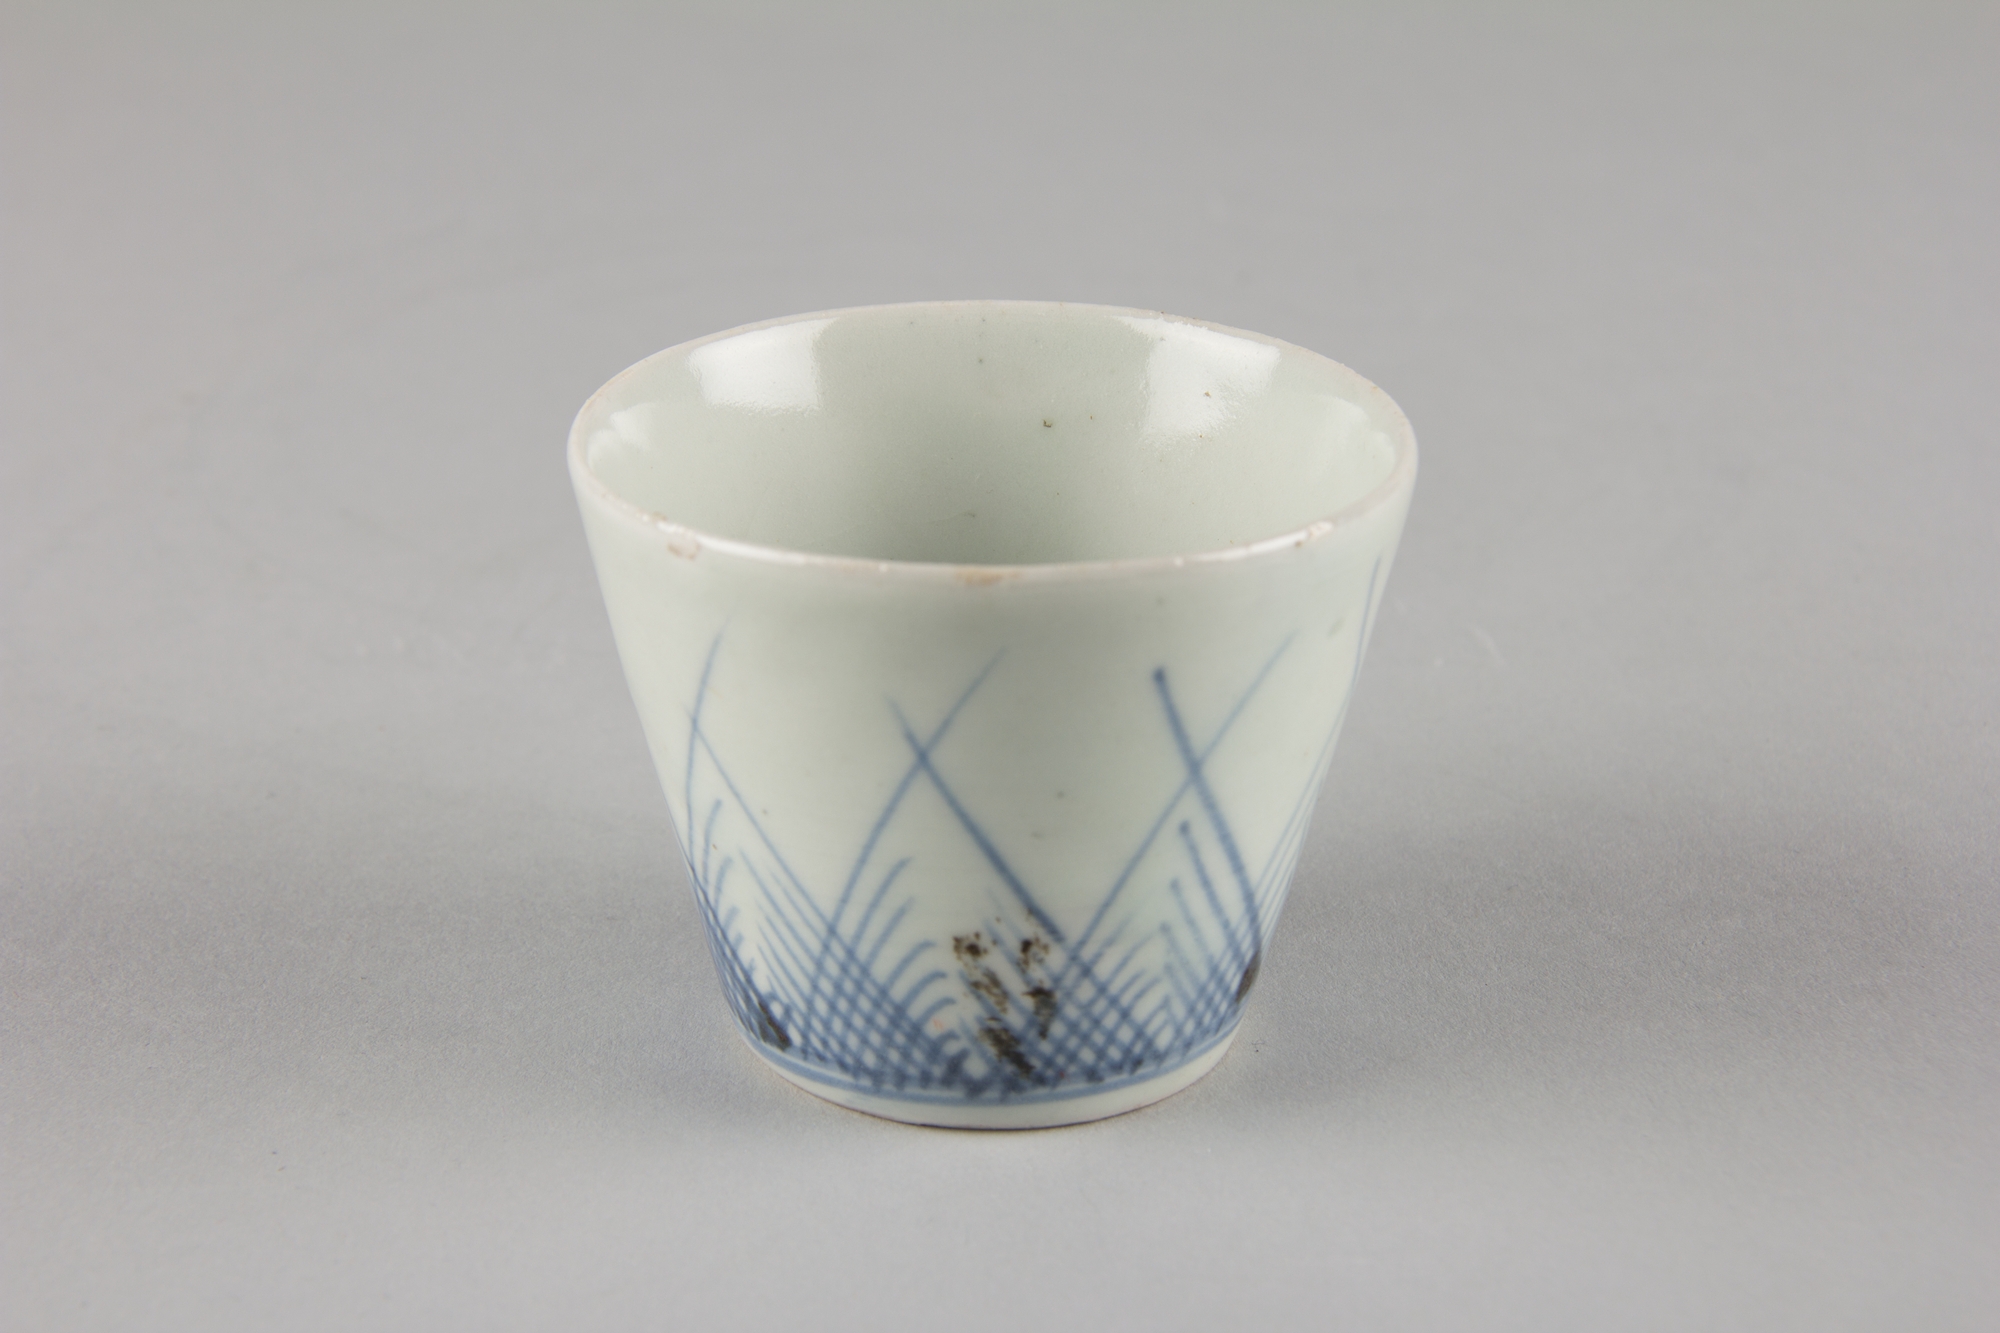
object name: soba cup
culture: japanese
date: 1734-1800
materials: porcelain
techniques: underglaze